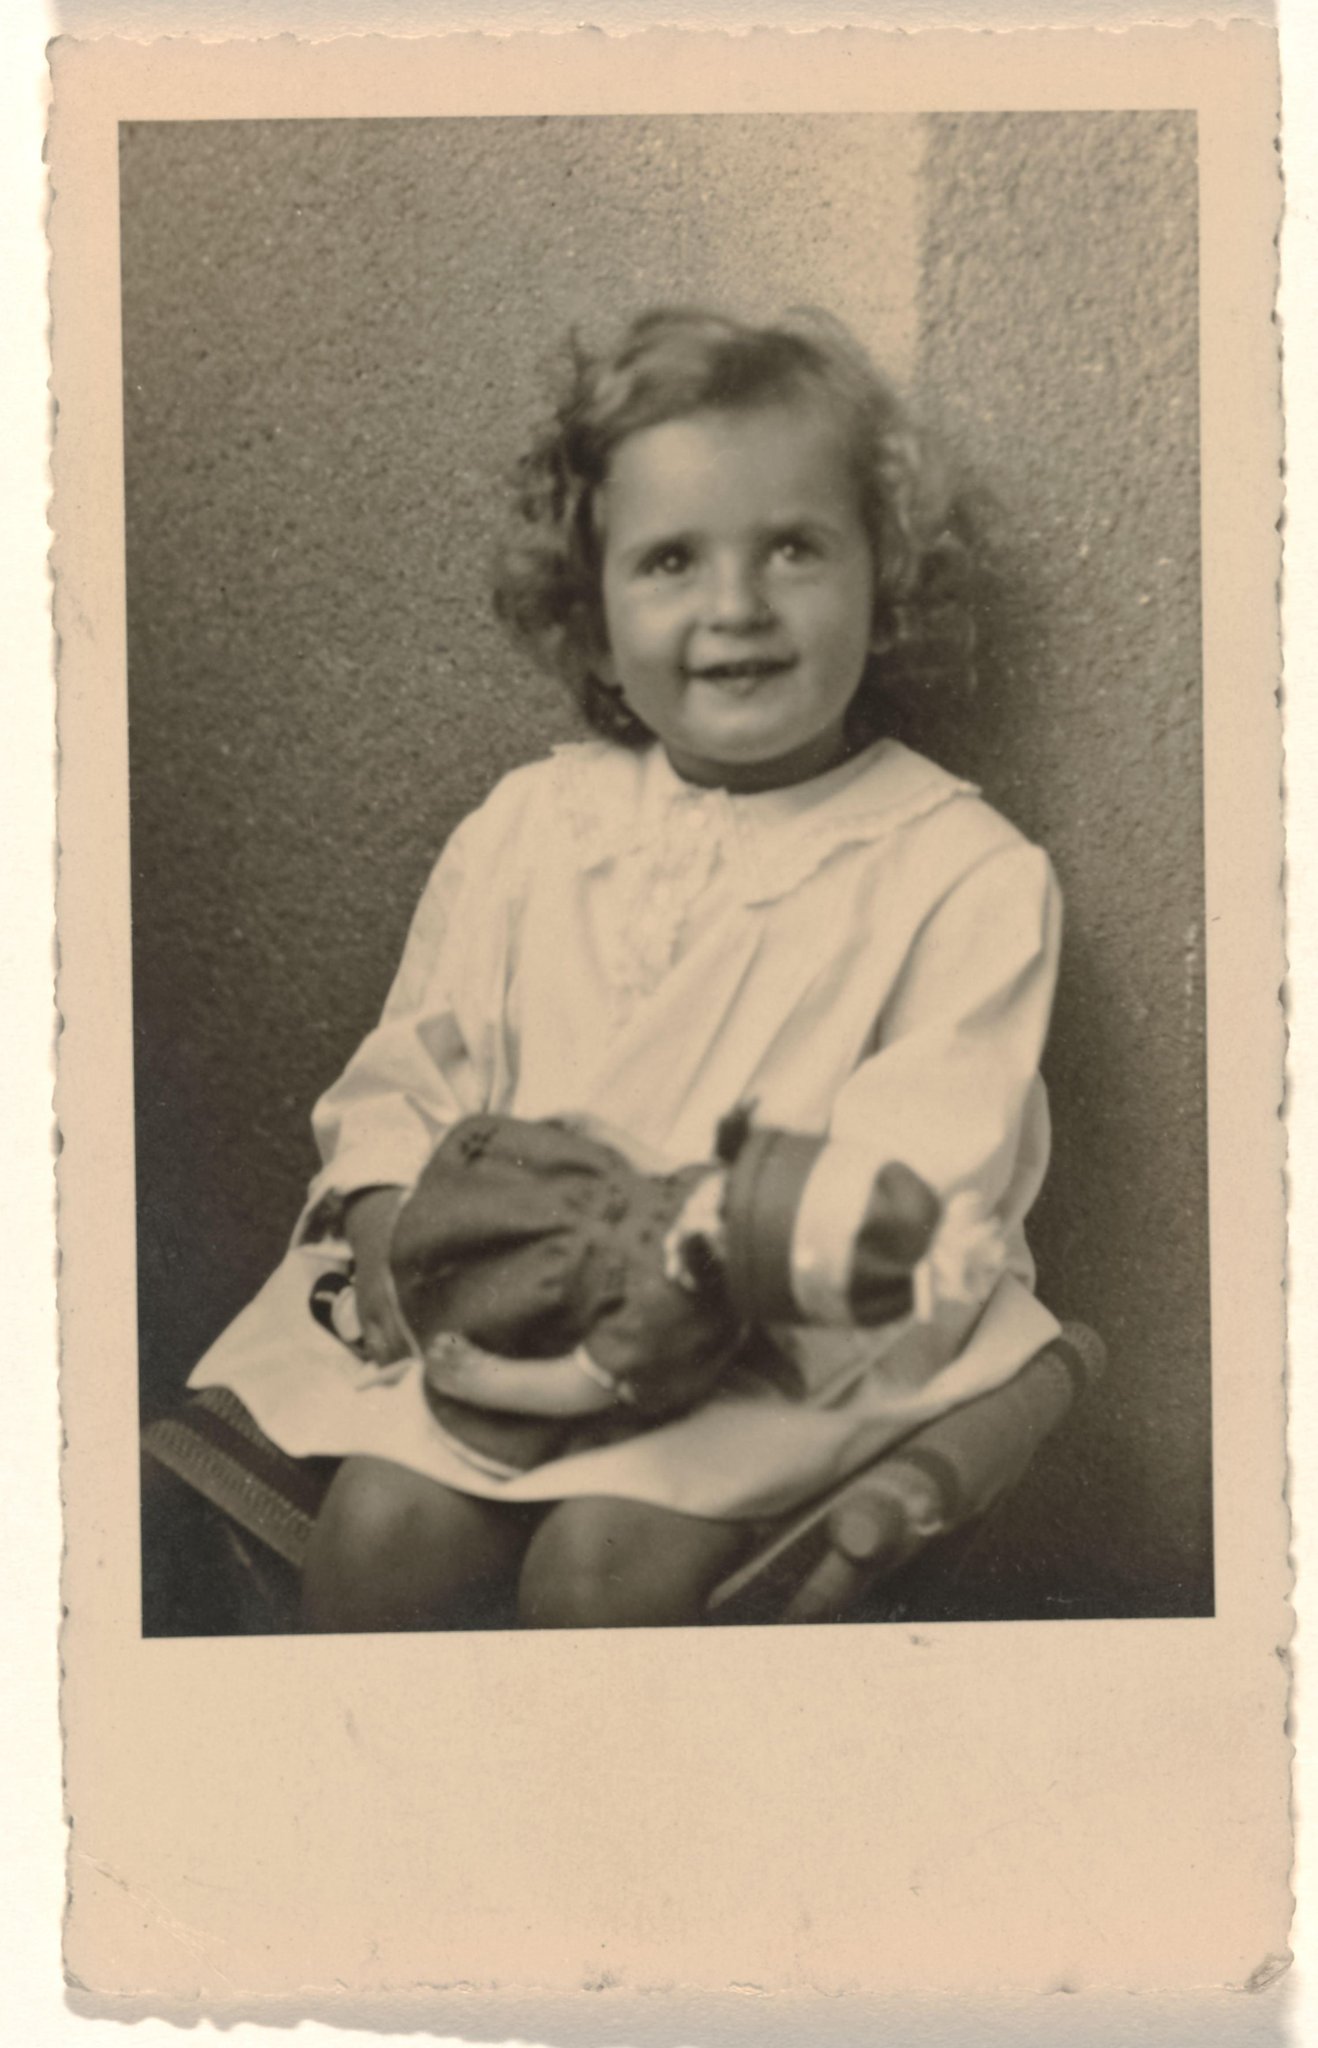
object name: photograph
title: Isabel Wachenheimer op de voorkant van een verjaardagskaart aan Hermann Zürndorfer, 26 augustus 1930, München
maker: Anonymous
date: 1930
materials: photographic support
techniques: gelatin silver print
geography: munich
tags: leiden, isabel wachenheimer-elon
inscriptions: inscription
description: Isabel Wachenheimer op de voorkant van een verjaardagskaart aan Hermann Zürndorfer.